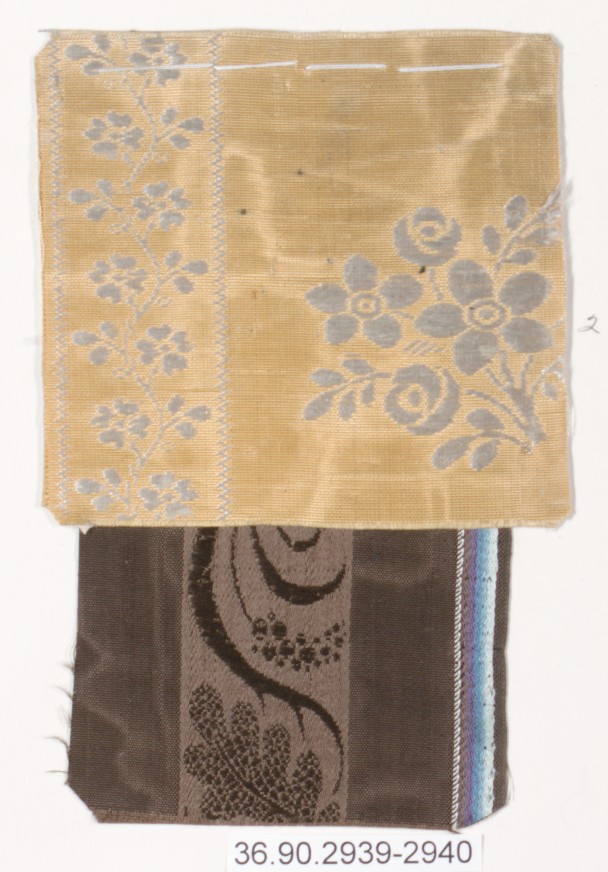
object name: piece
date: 1801-1900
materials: silk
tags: flowers,leaves